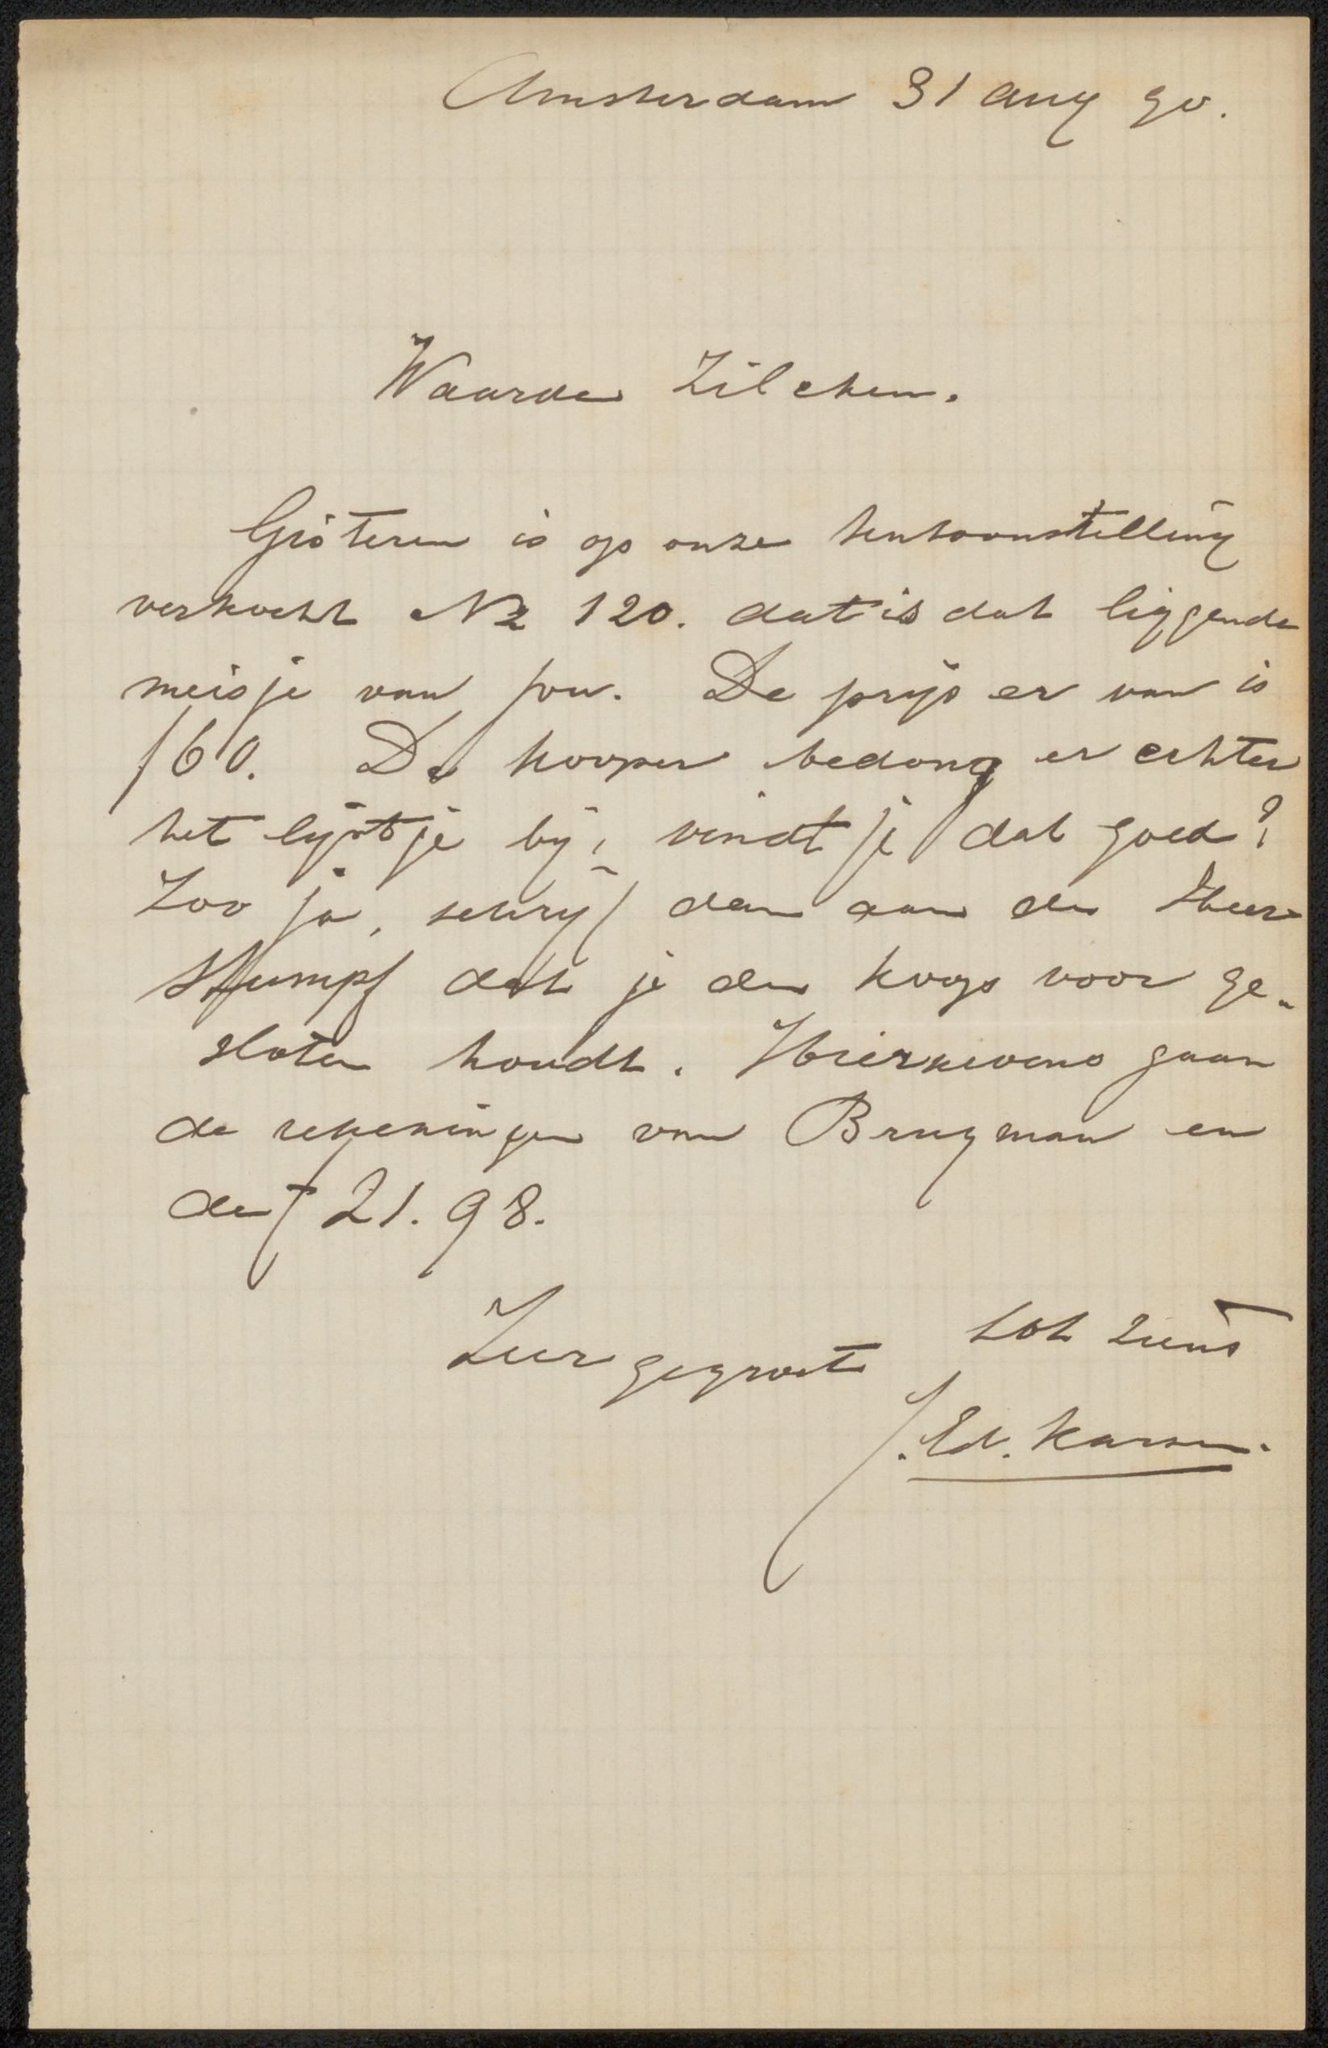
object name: letter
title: Brief aan Philip Zilcken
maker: eduard karsen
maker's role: draughtsman, painter, print maker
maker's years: 1860-1941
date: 1890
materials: ink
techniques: pen, writing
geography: amsterdam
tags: the hague, philip zilcken, exhibition ~ art, money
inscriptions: collector's mark: ‘RPK’